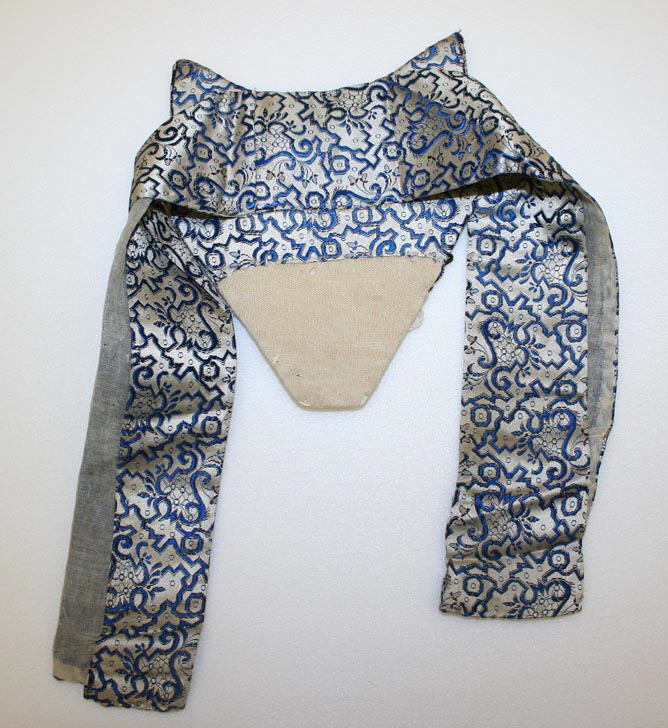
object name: necktie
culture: american or european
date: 1840-1845